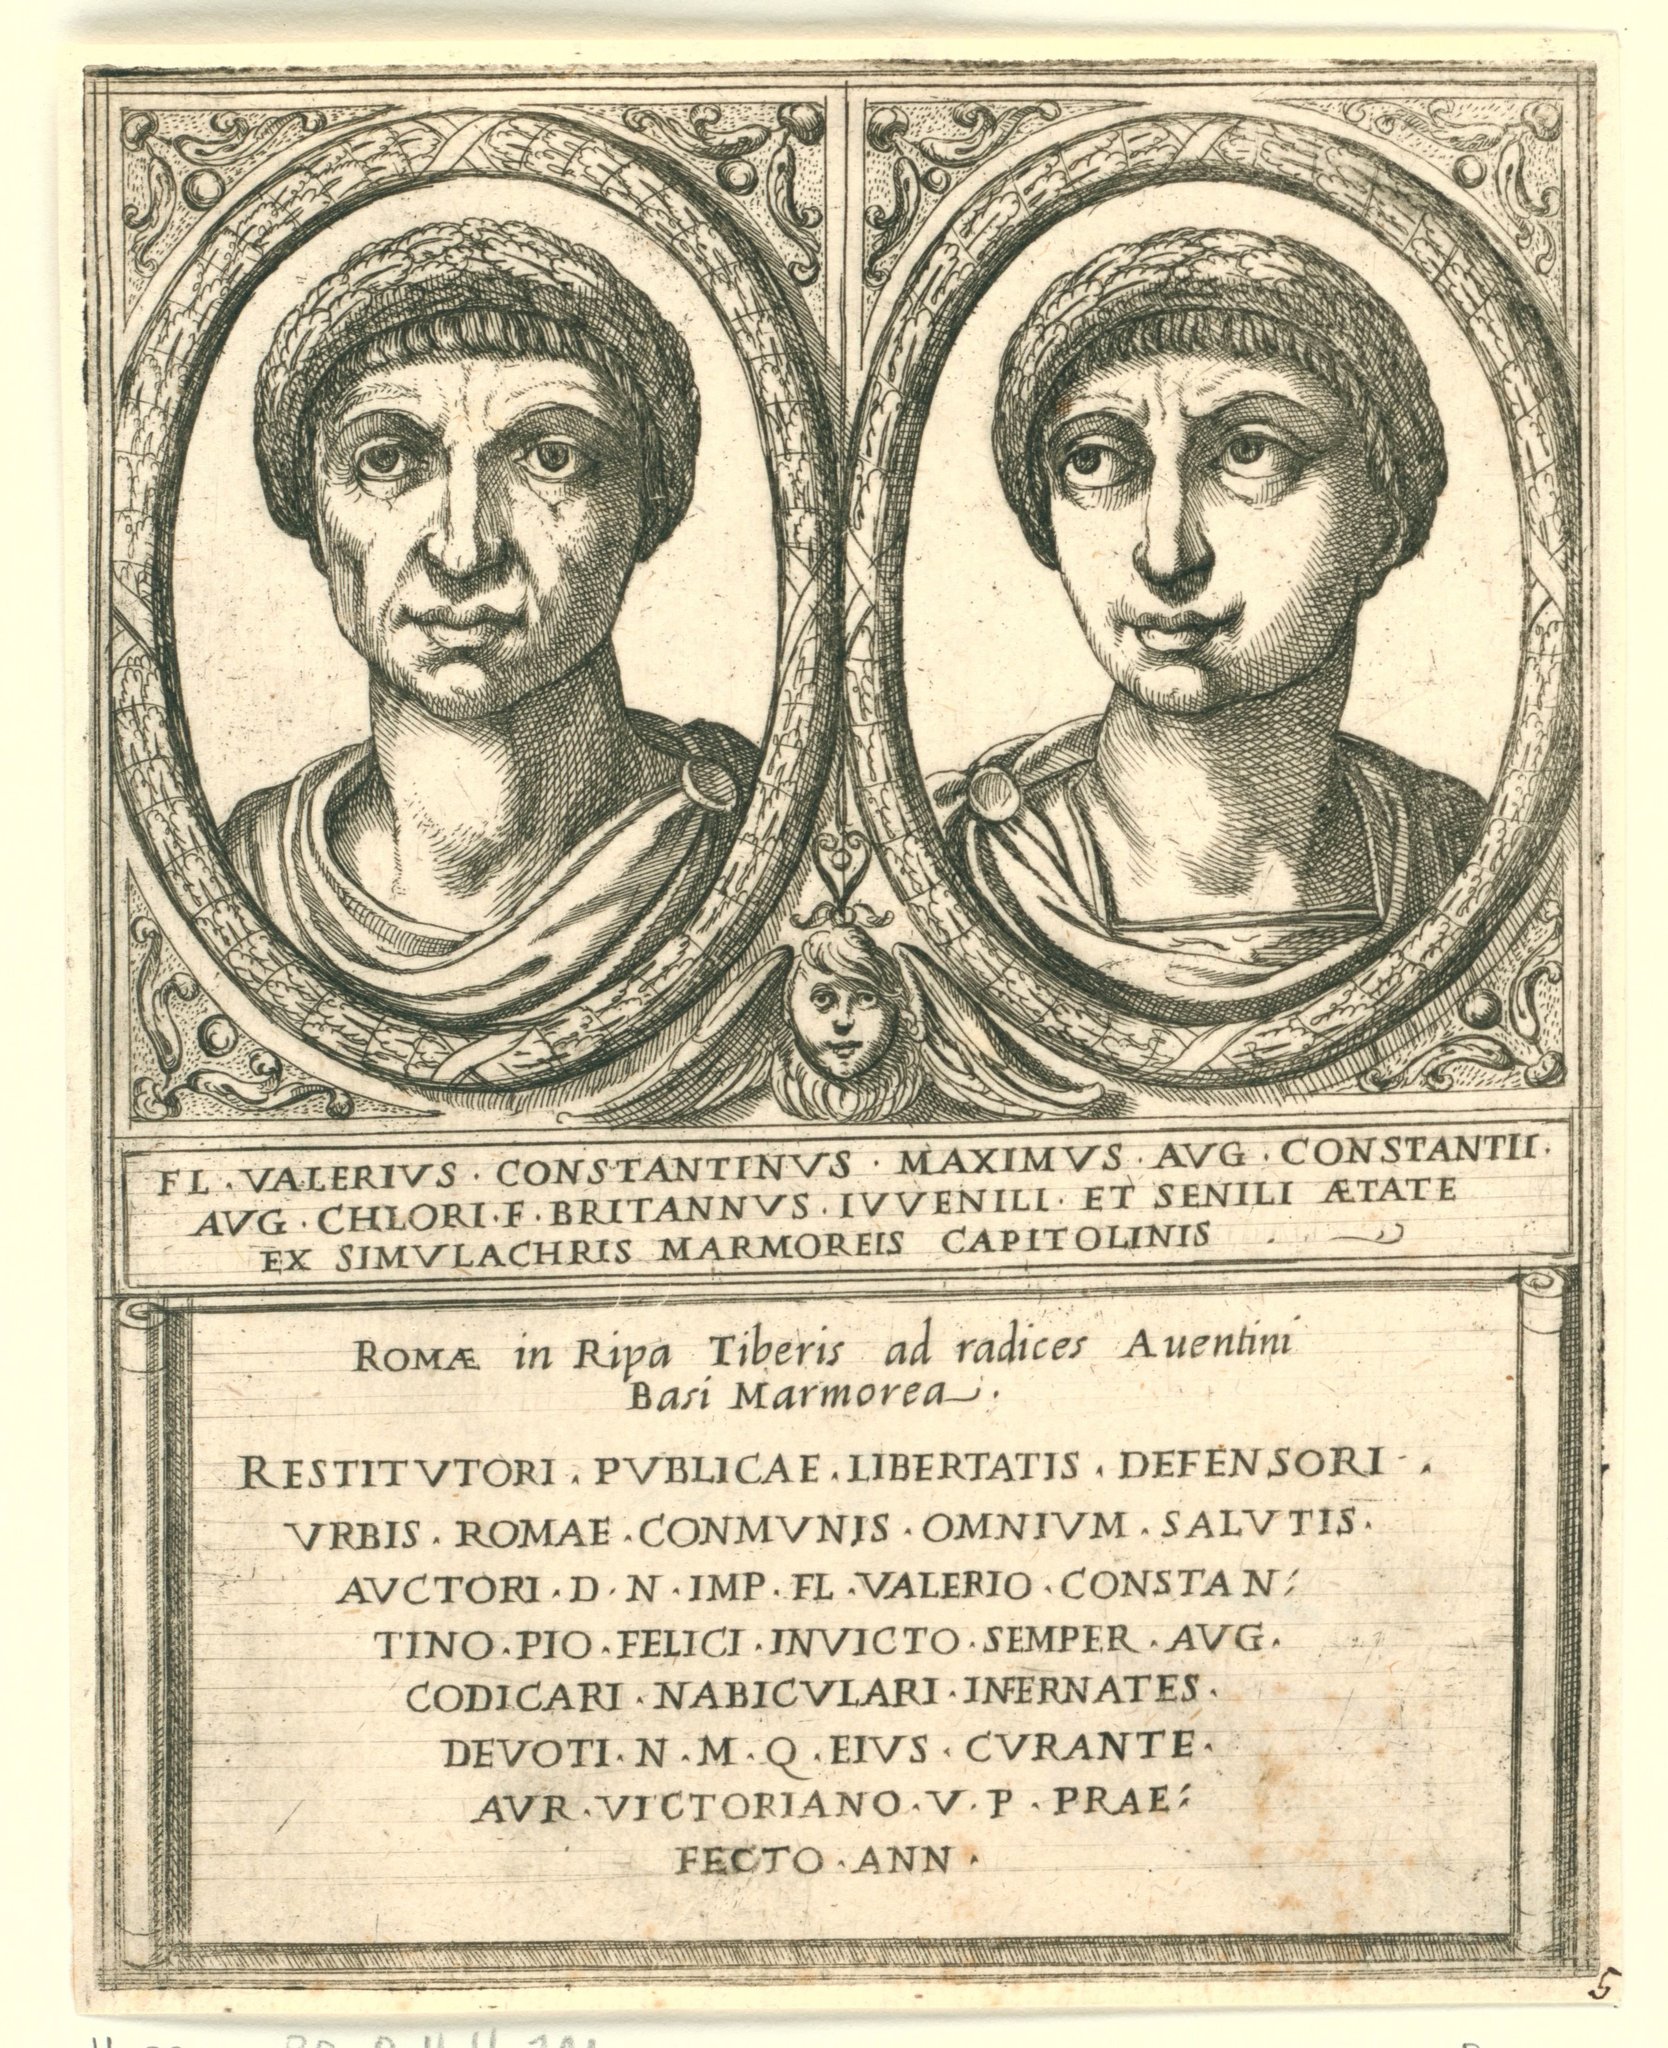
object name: print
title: Isagogia historia de Constantino max: imperatore instatuta militie angelicae aureatae Constantinianae sub titulo magni martyris S Georgii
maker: antonio tempesta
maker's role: draughtsman, painter, print maker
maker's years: 1555-1630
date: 1565-1630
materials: paper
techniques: etching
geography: italy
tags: historical persons, emperor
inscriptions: number: ‘5’, collector's mark: ‘Hinloopen’, collector's mark: Lugt 11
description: Twee ovale lijsten met in de linker een portret van keizer Constantijn de Grote op oudere leeftijd en in de rechter een portret van de keizer op jongere leeftijd. Onder de portretten tekst in het Latijn.